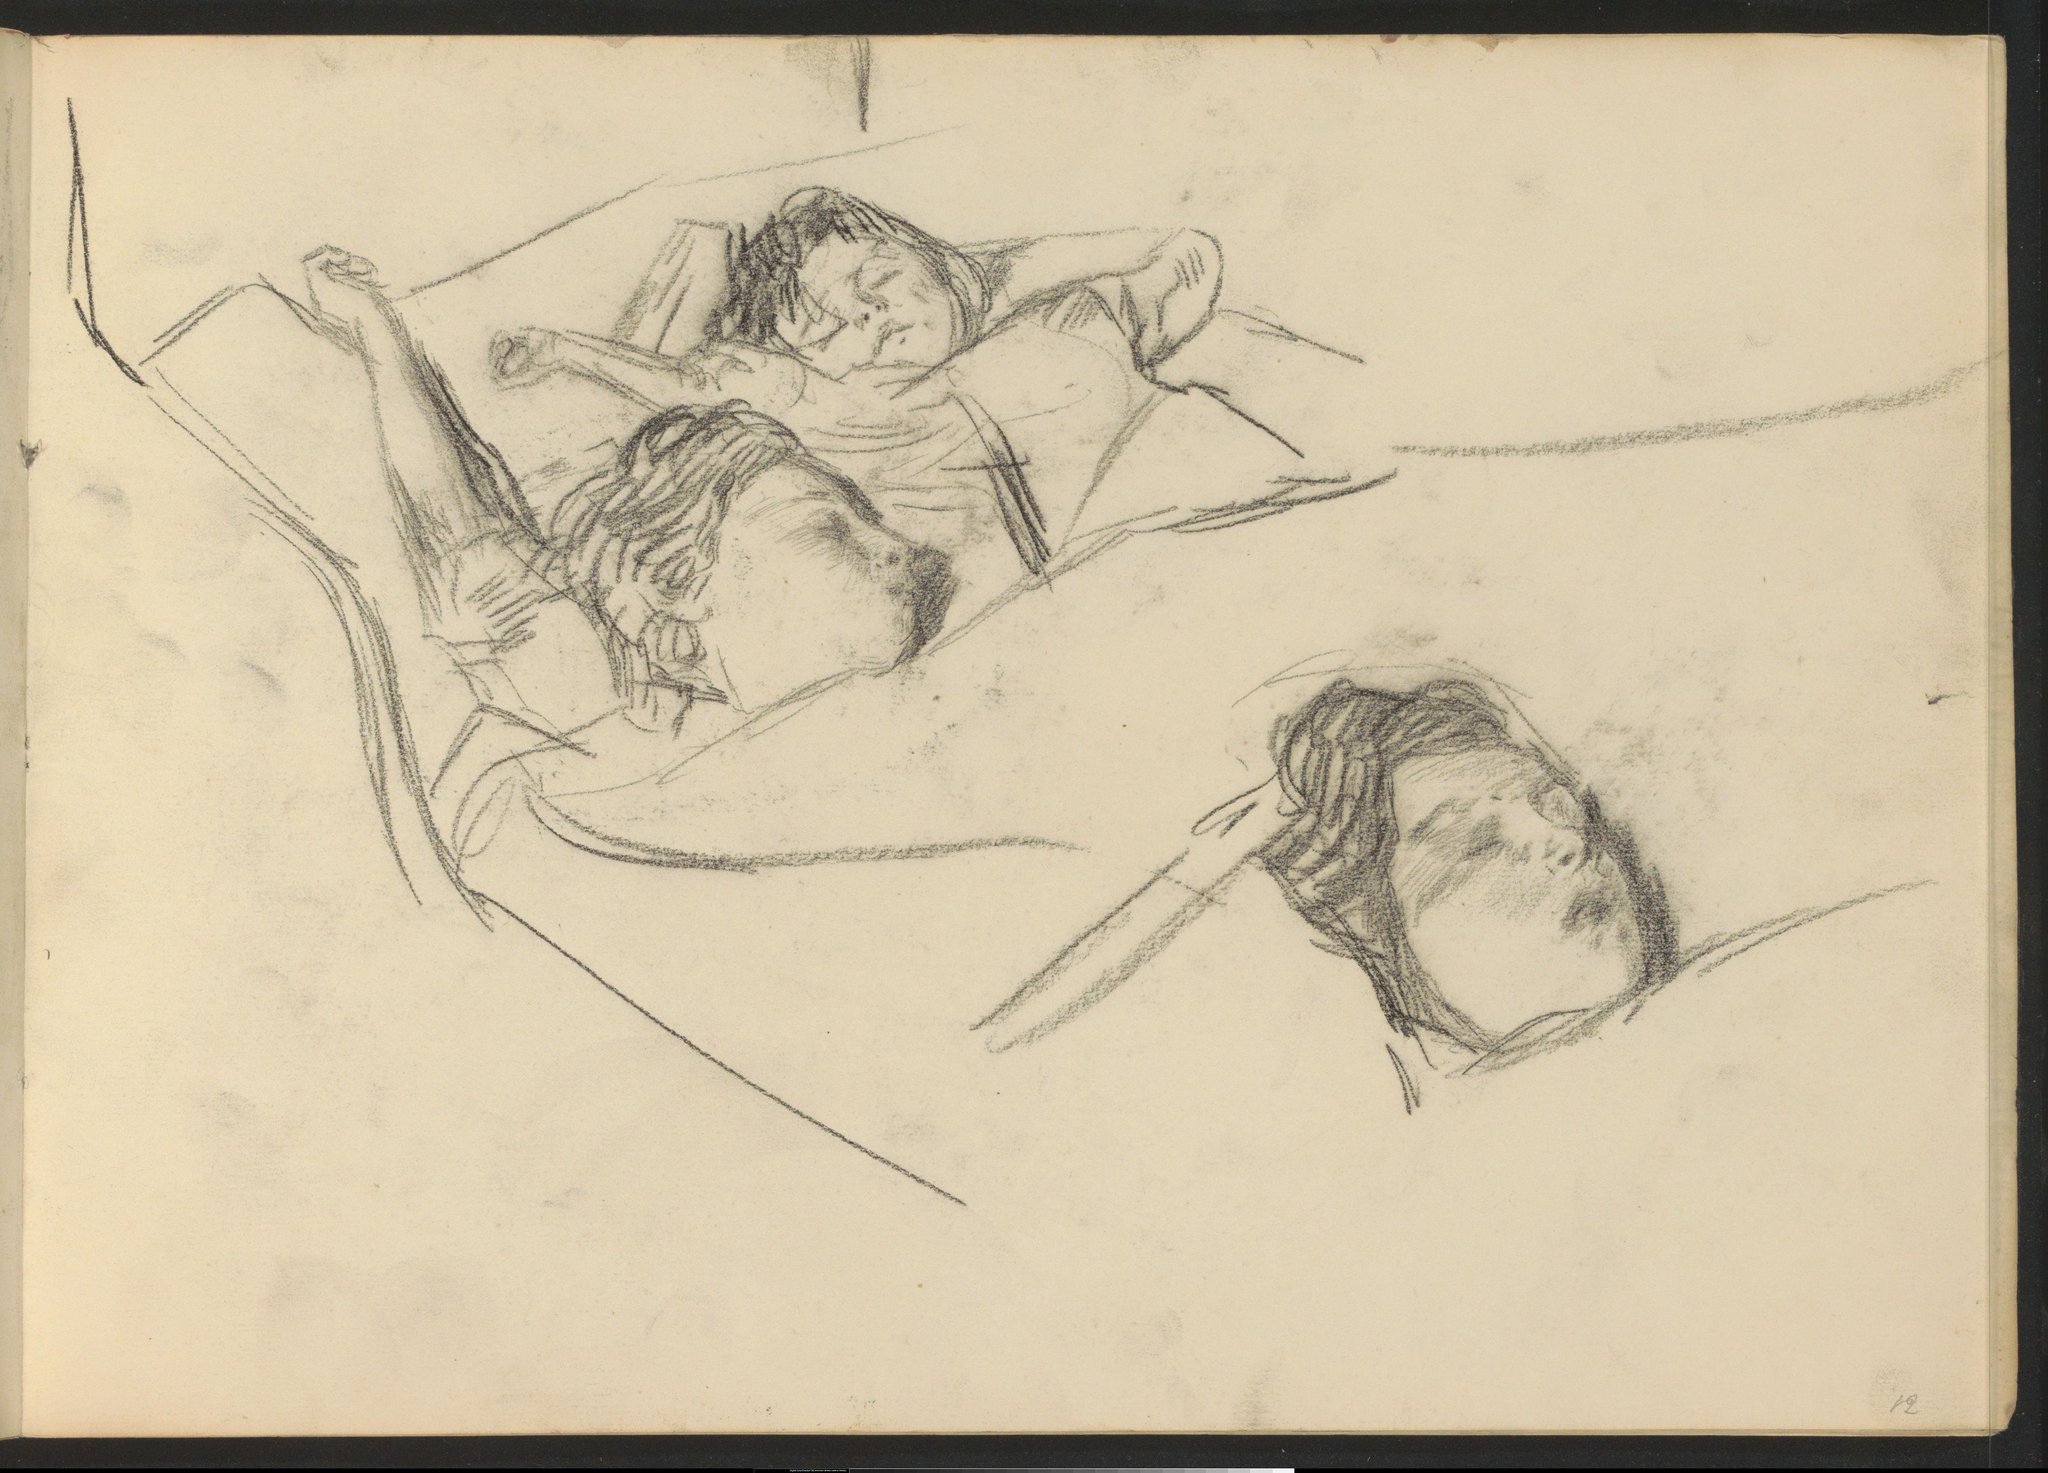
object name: sketchbook leaf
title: Twee slapende kinderen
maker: isaac israels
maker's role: draughtsman, painter, print maker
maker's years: 1865-1934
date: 1875-1934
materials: chalk, paper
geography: the hague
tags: sleeping in bed, child (+ two persons)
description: In bed. Blad 12 recto uit schetsboek XII met 19 bladen.